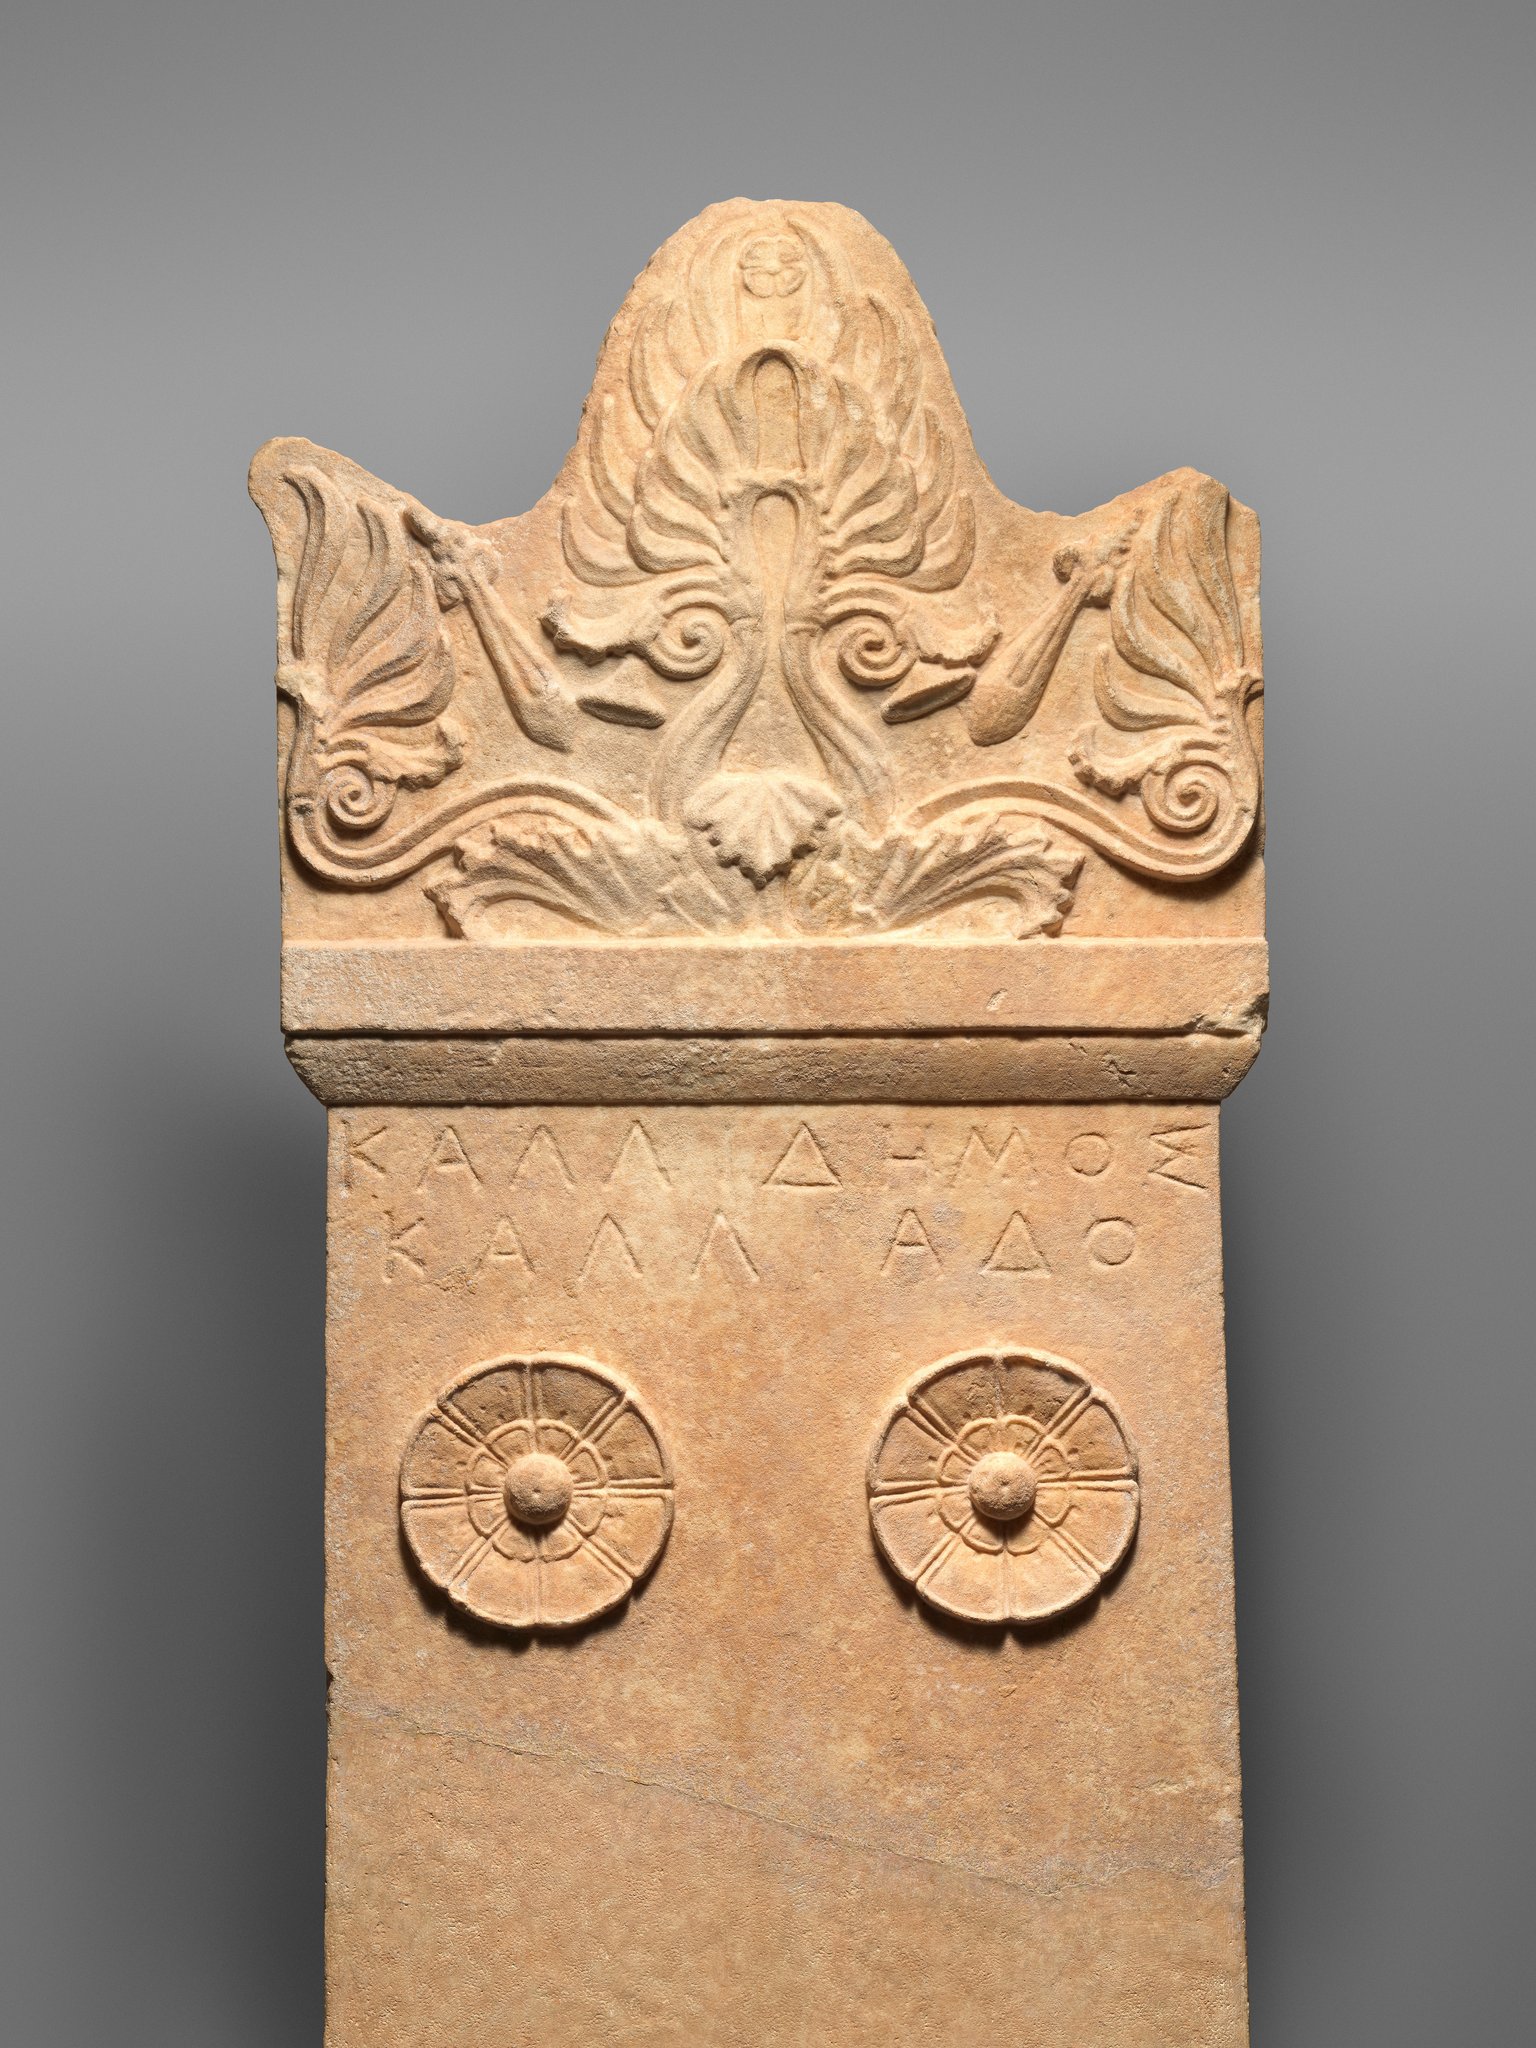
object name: grave stele of kallidemos, upper part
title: Upper part of the marble stele (grave marker) of Kallidemos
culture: greek, attic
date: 350-325 BCE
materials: marble